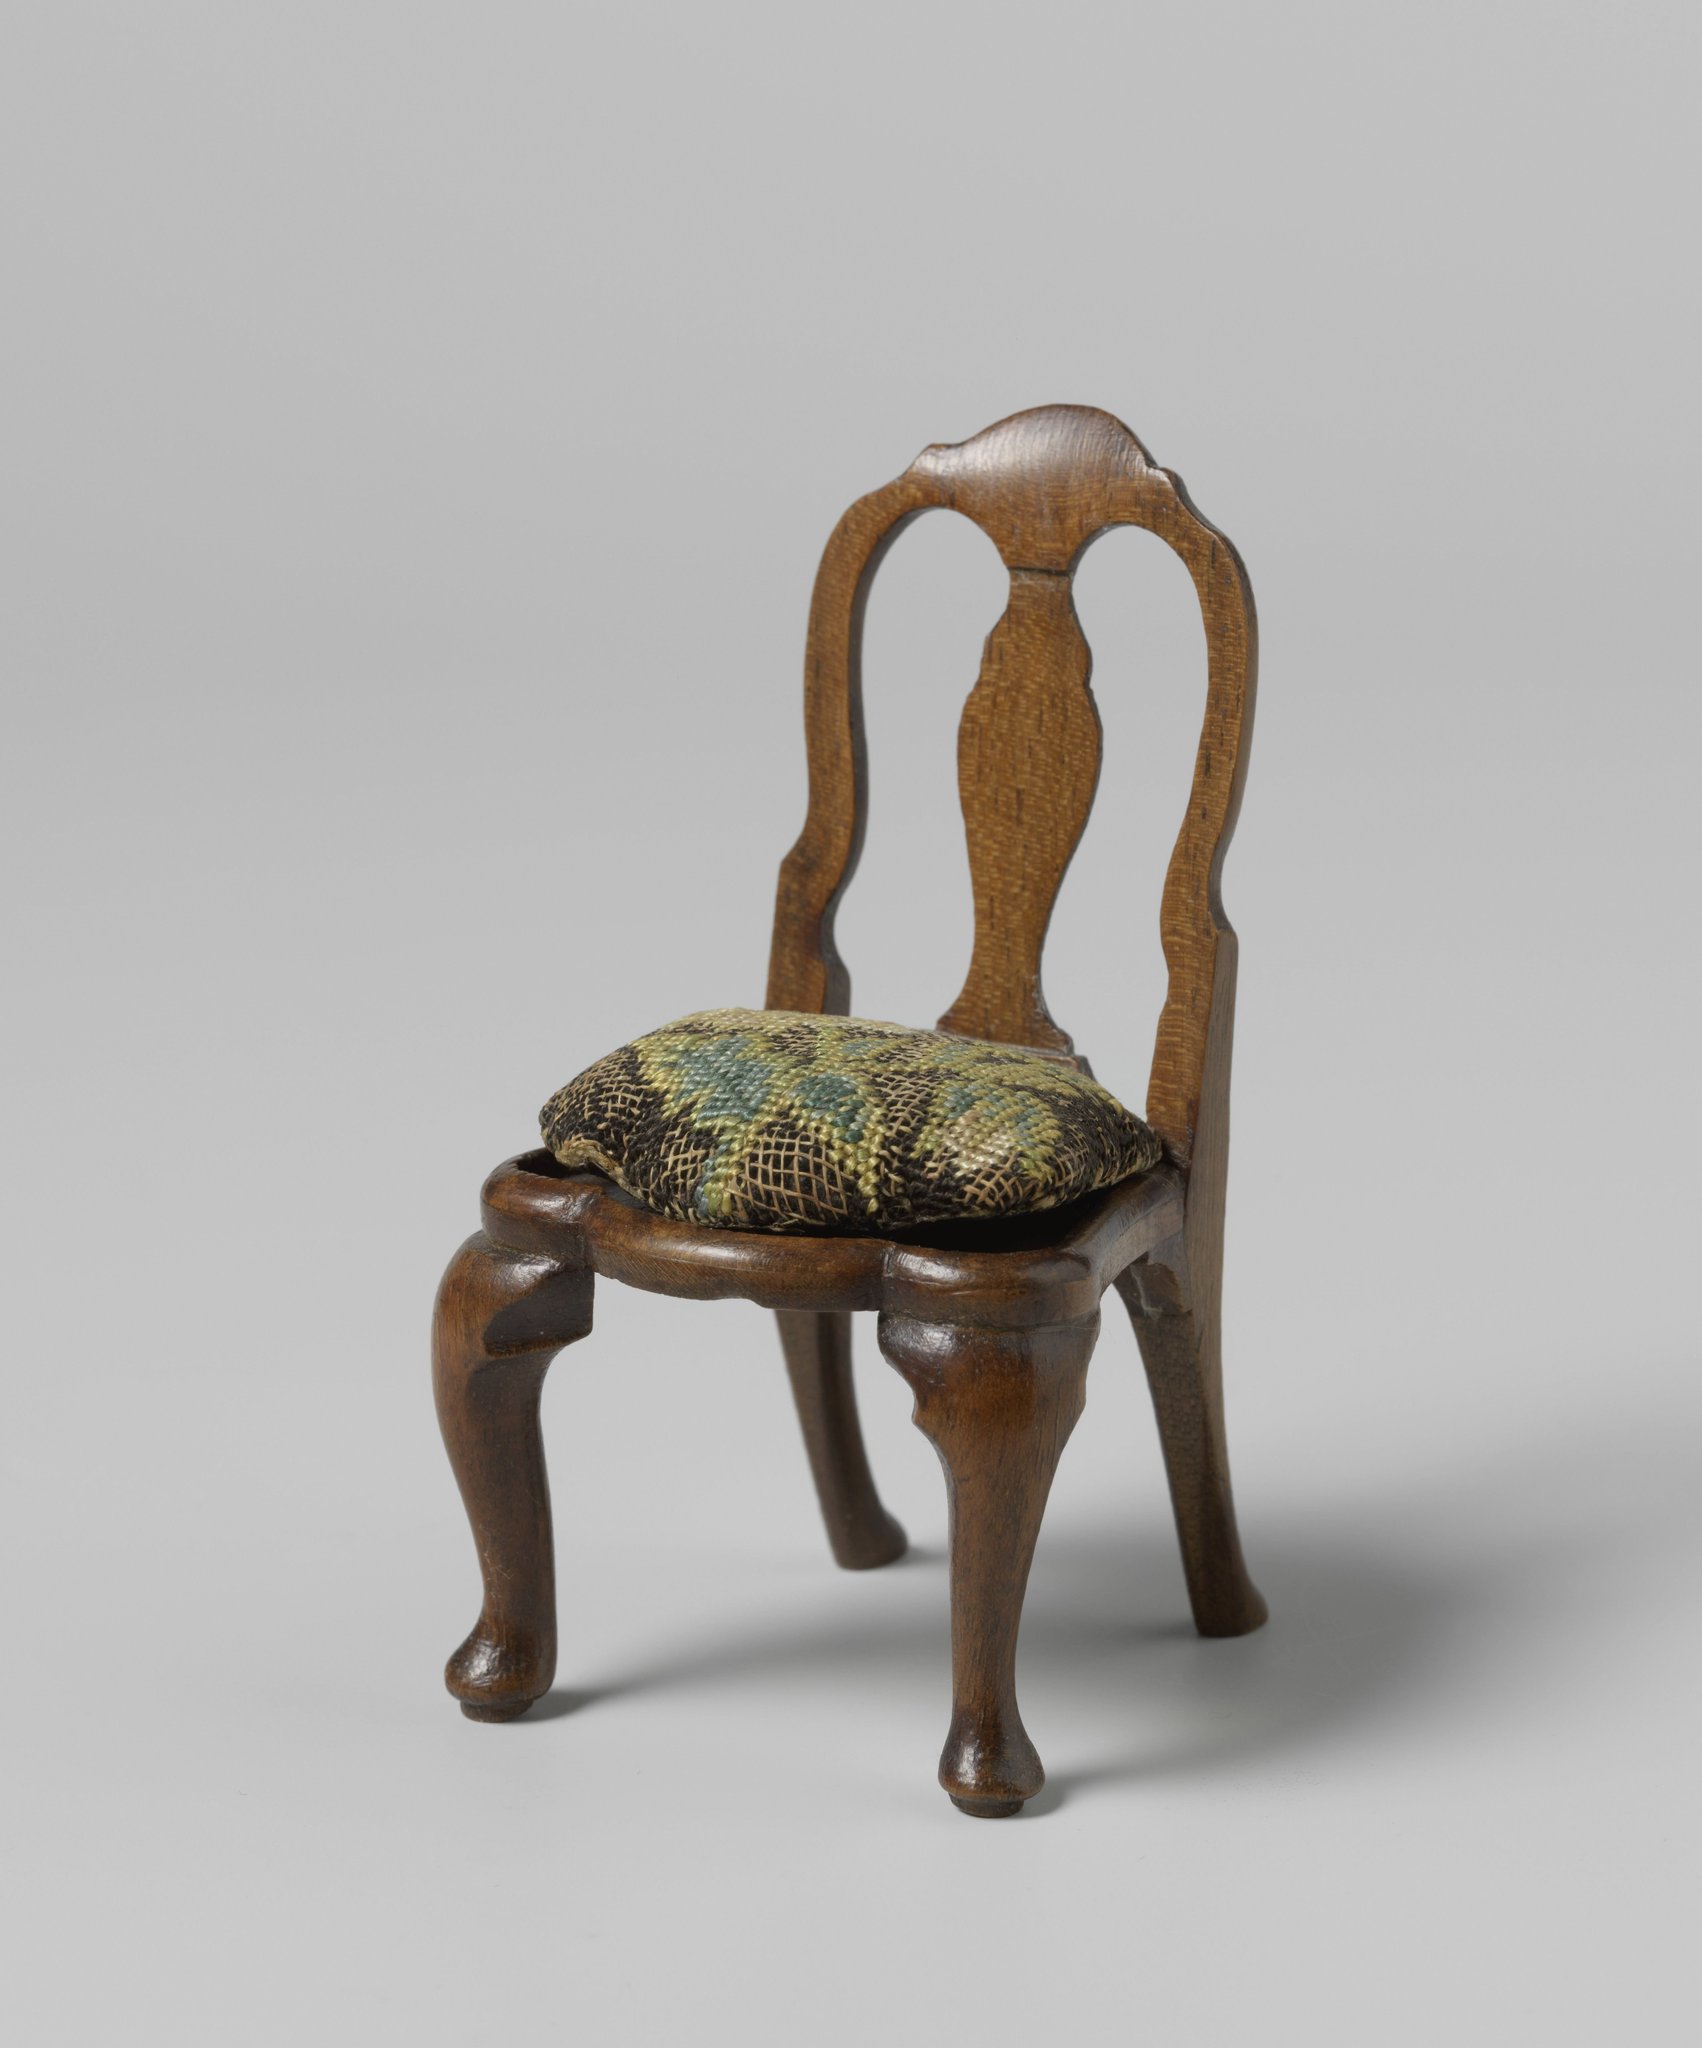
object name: chair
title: Stoel, behorend tot een elfdelig ameublement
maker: Anonymous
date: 1750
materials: silk, wood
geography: amsterdam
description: Stoel, vervaardigd van notenhout, behorend tot een elfdelig ameublement, bestaande uit een bank en tien stoelen. De zitting van buurduurwerk met blad- en bloemmotieven in zijde op linnen stramien, met een zachte vulling.